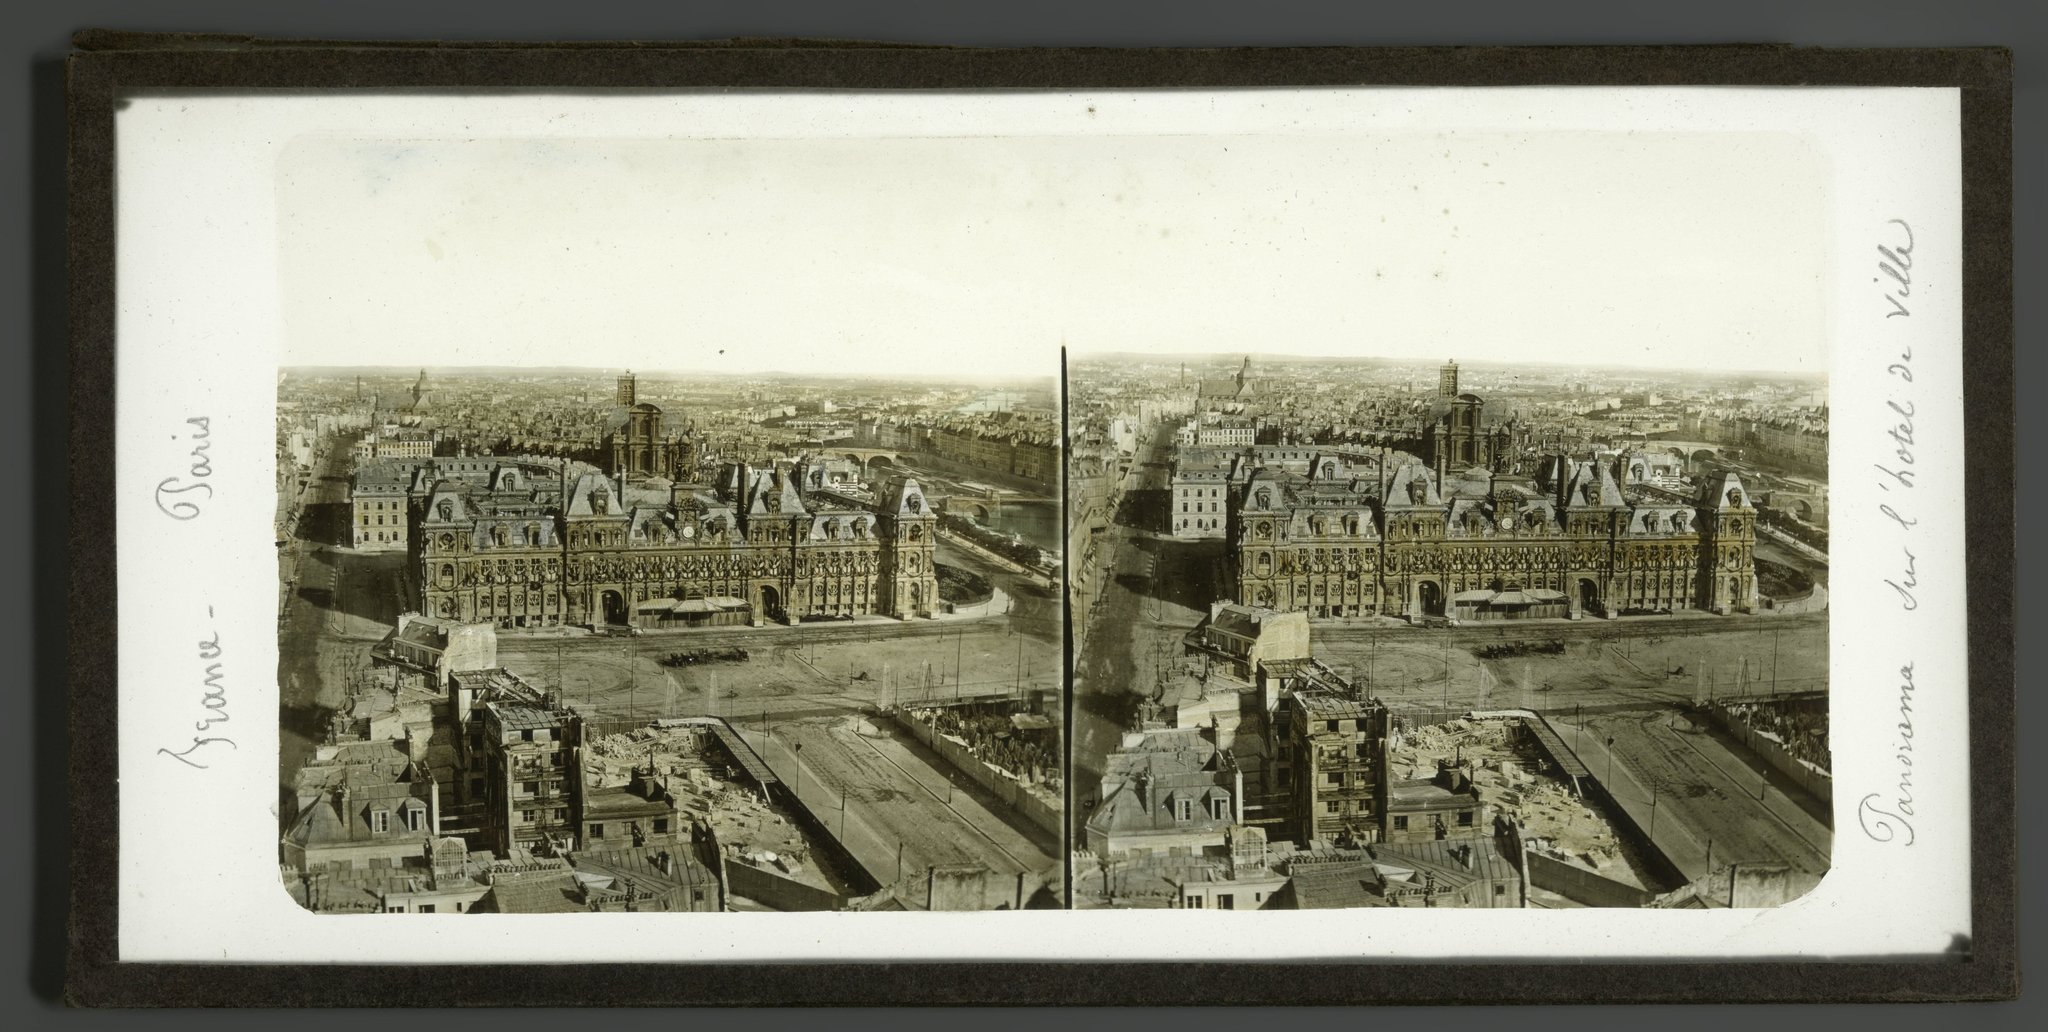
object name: stereoscopic photograph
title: Gezicht op het Stadhuis te Parijs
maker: Anonymous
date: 1856-1890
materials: glass, paper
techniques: hand coloring, slide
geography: paris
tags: townhall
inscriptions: annotation: ‘France-Paris/ Panorama sur l'hotel de ville’